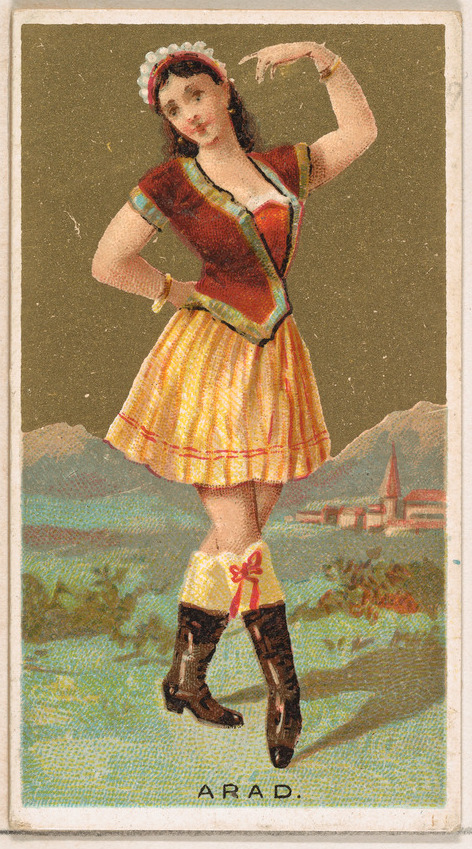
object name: print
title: Arad, from the Dancing Girls of the World series (N185) issued by Wm. S. Kimball & Co.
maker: william s. kimball & company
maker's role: publisher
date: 1889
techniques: color lithograph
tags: women,dancing